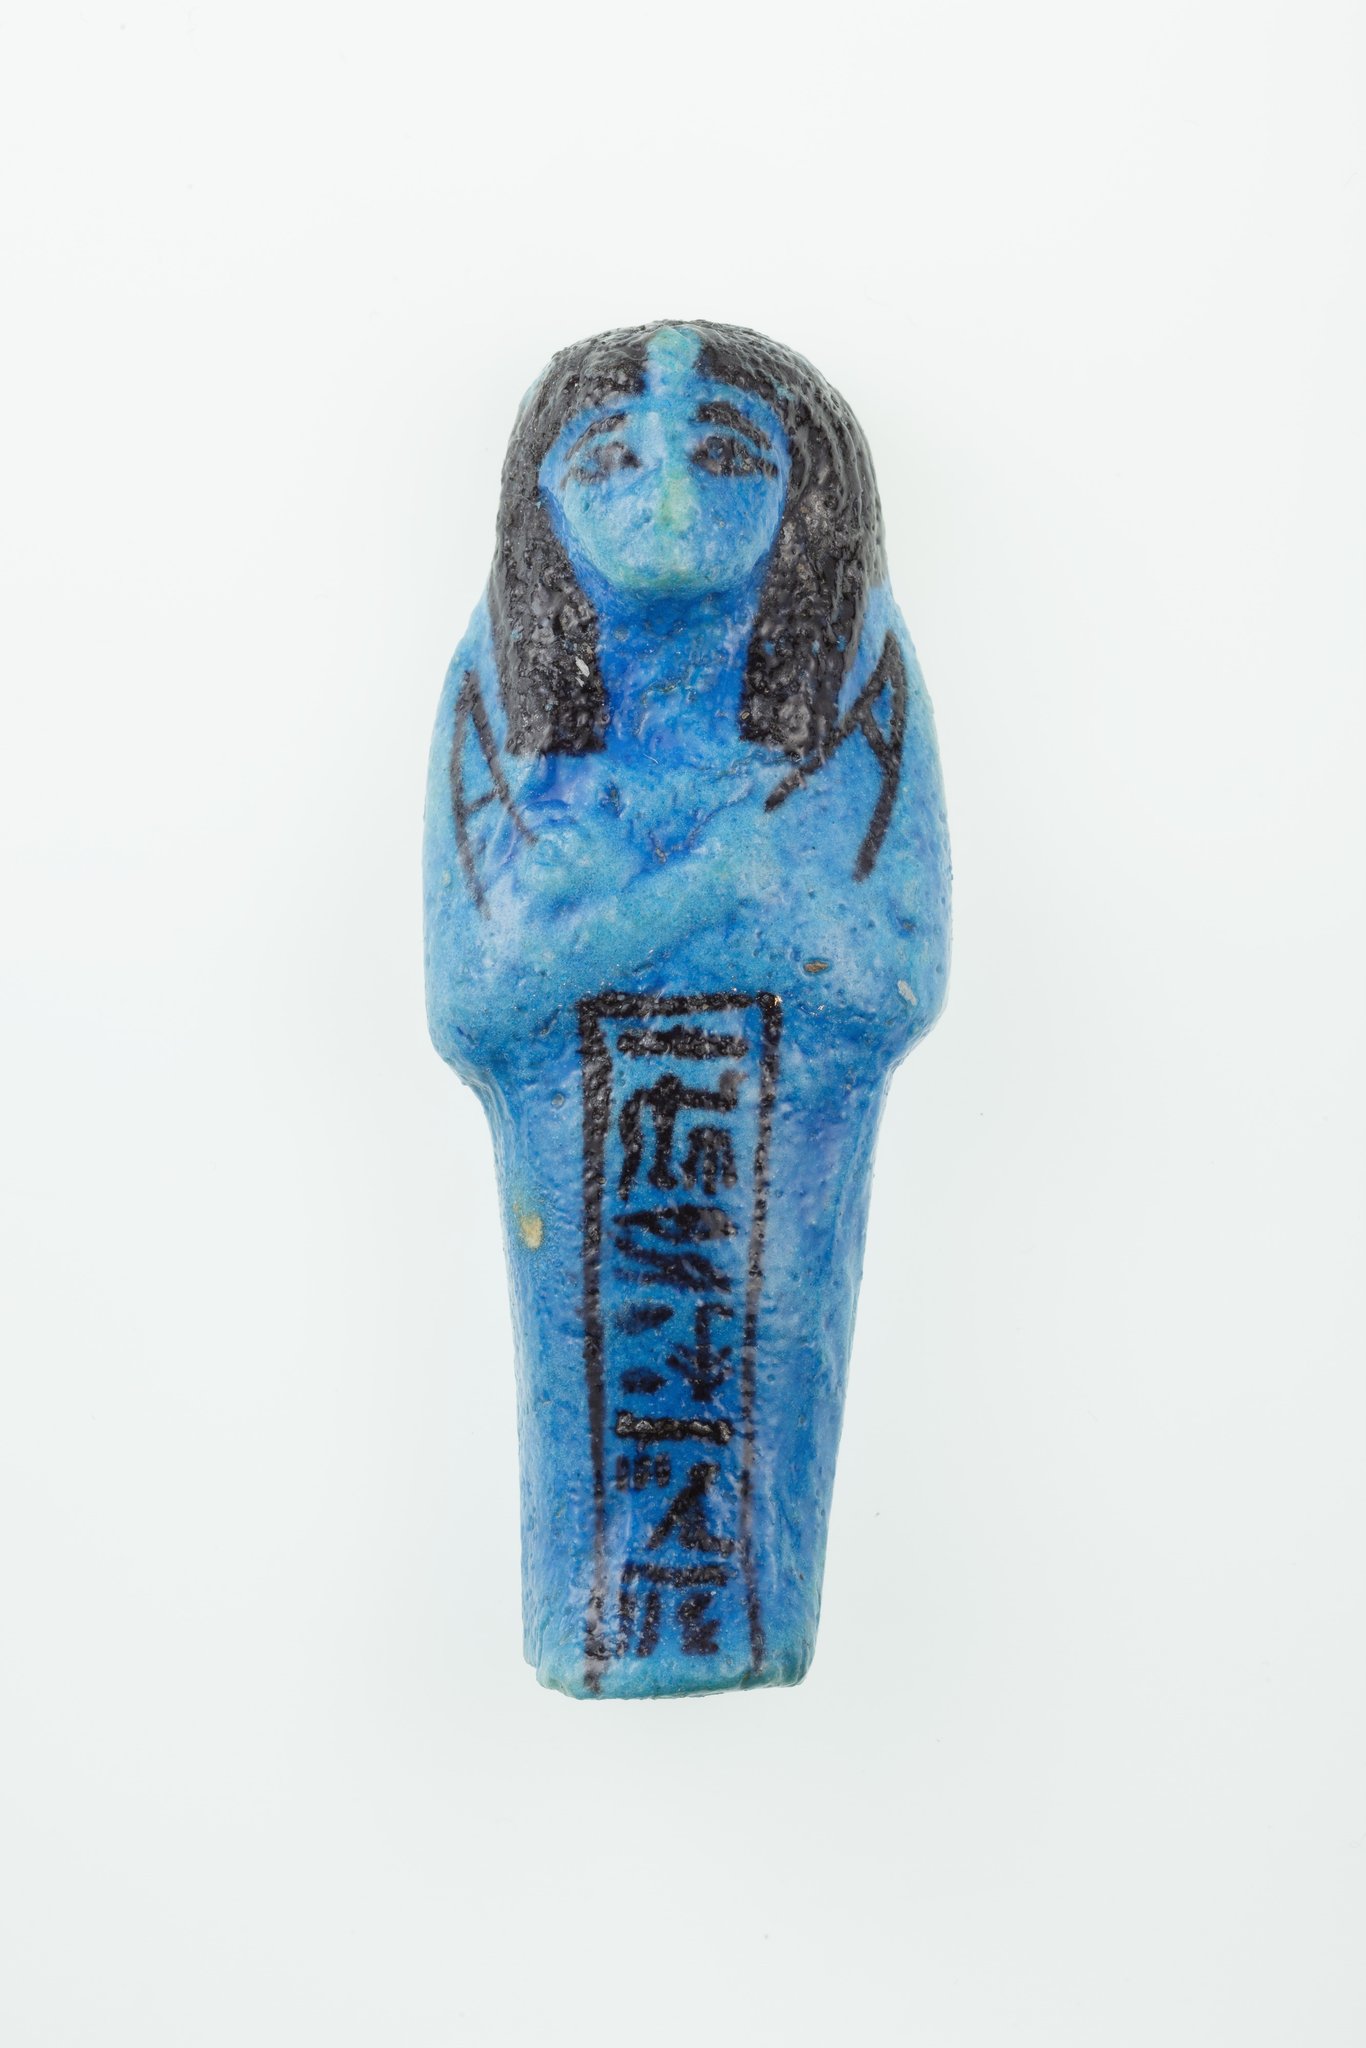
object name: shabti, nauny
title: Worker Shabti of Nauny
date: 1050 BCE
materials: faience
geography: egypt